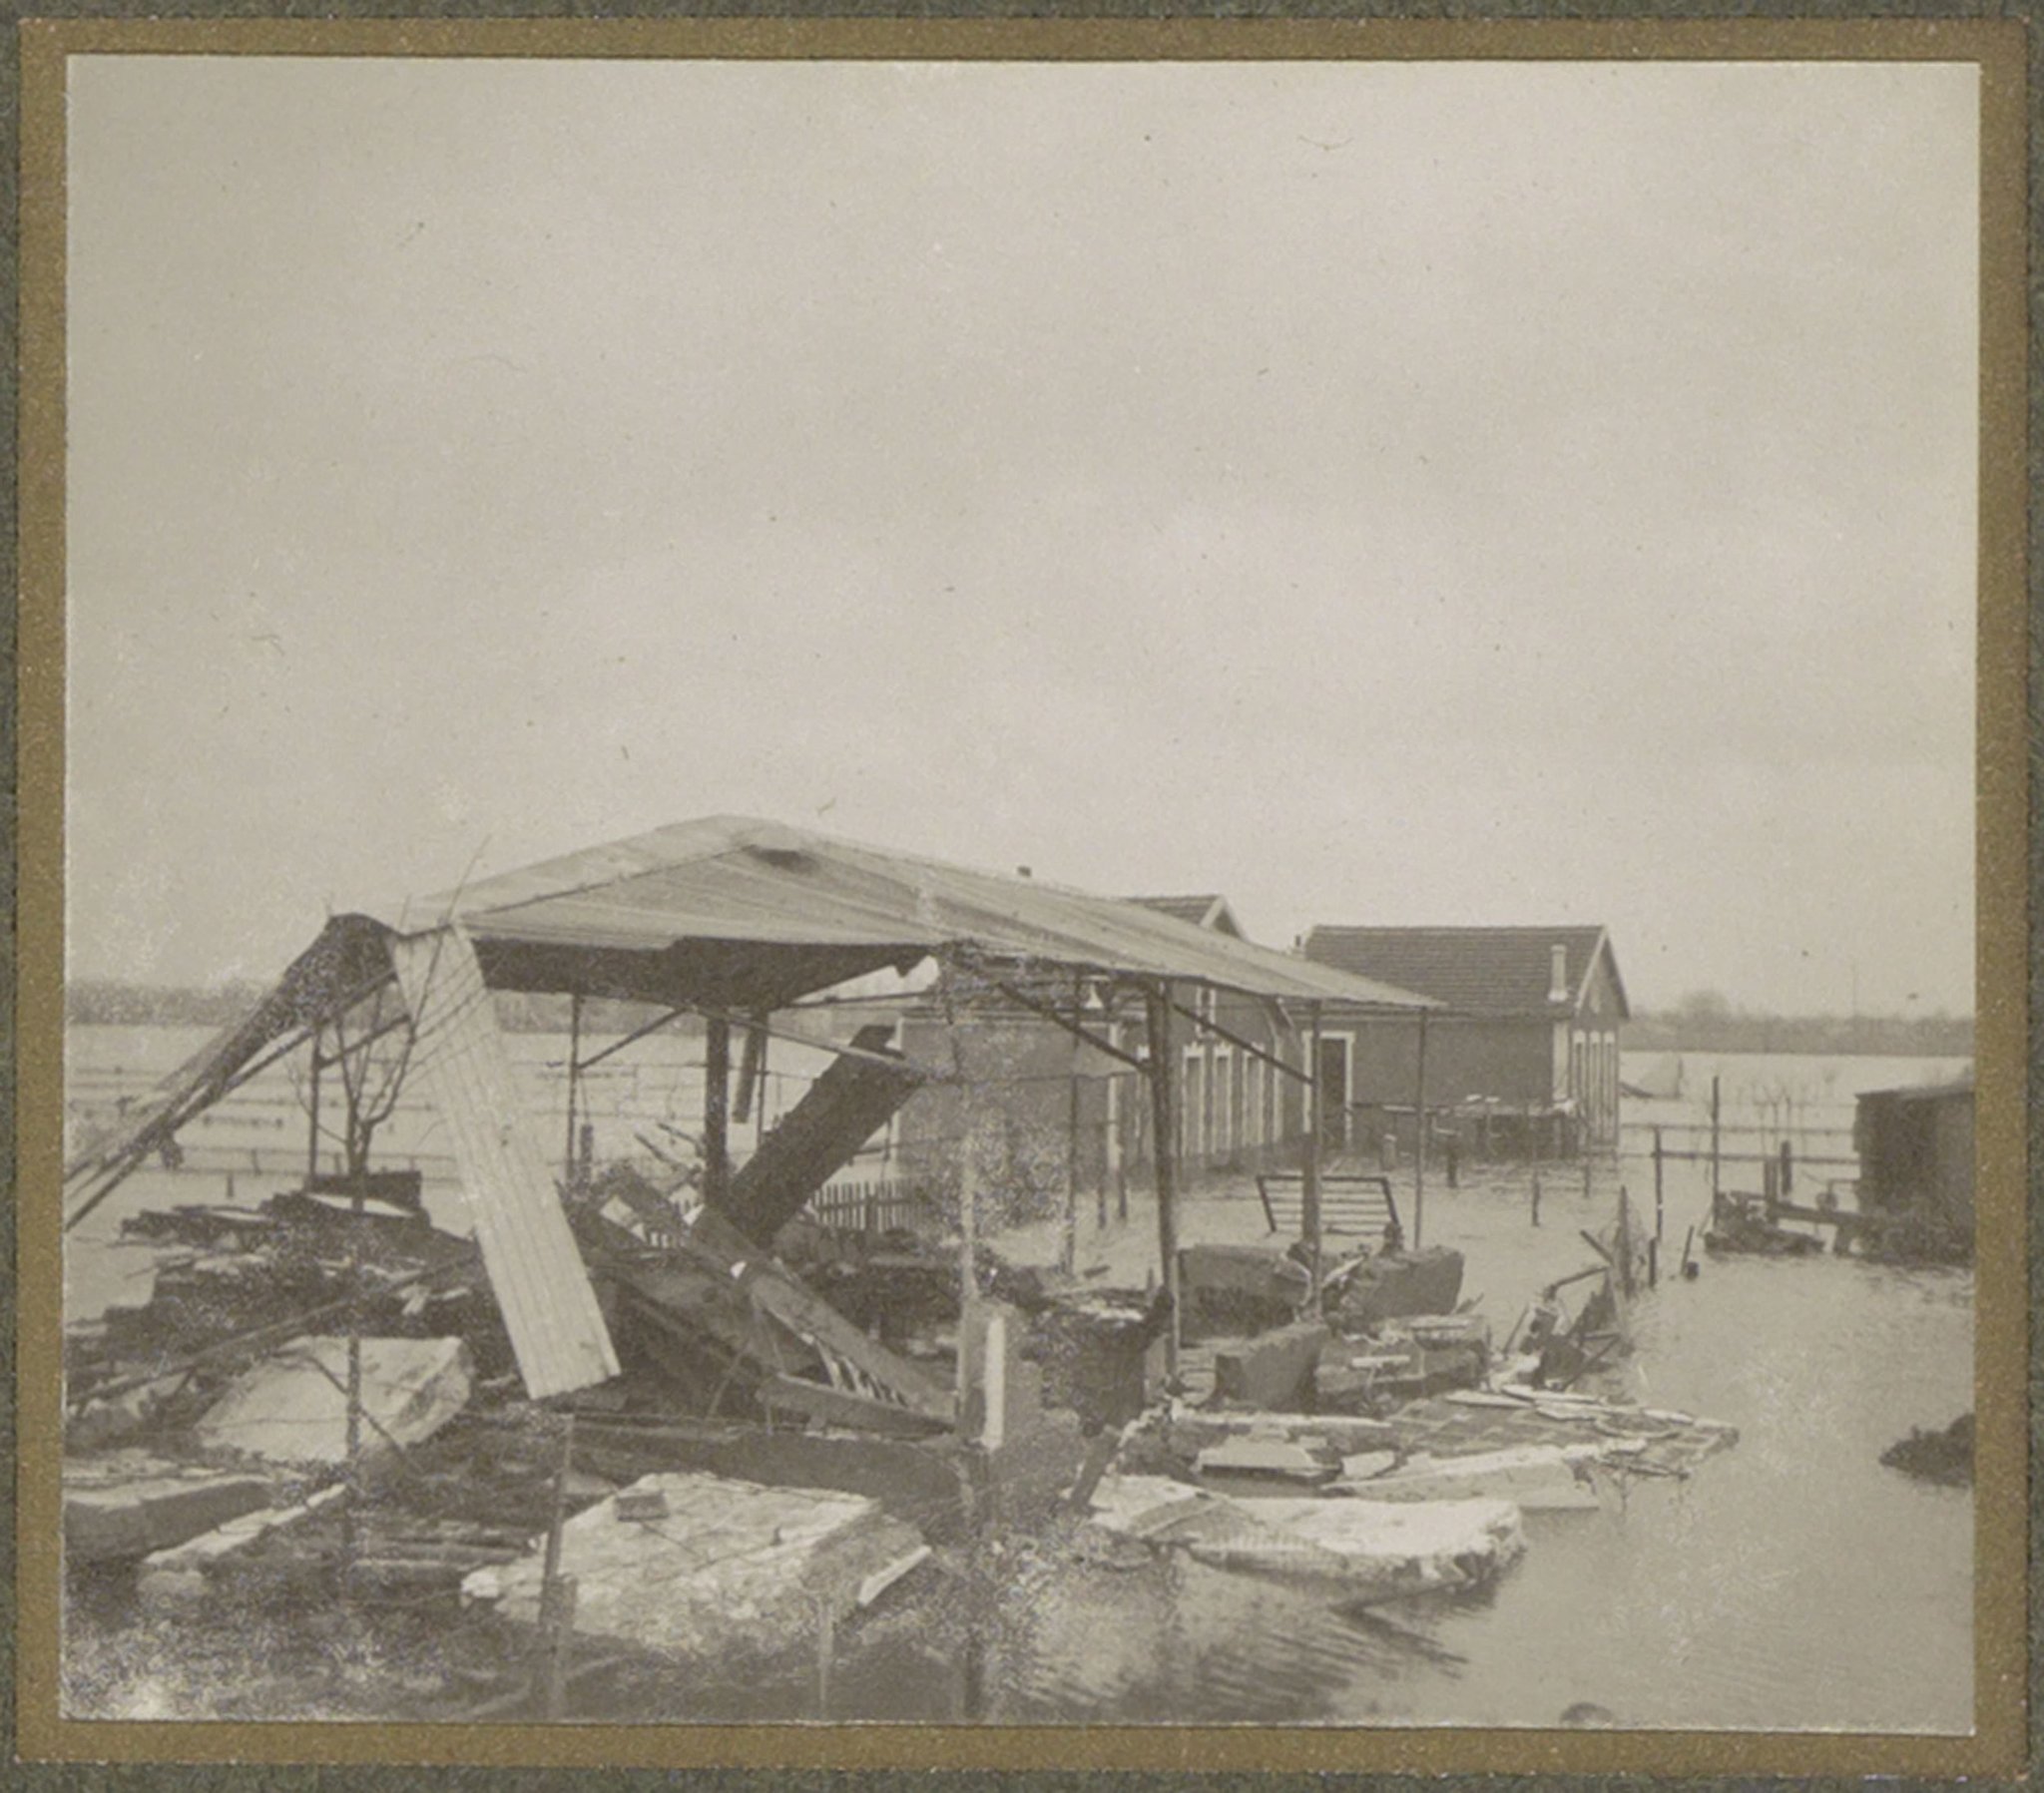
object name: photograph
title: Verwoeste schuur op ondergelopen land in een buitenwijk van Parijs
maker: g. dangereux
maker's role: fotograaf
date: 1901-1910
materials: photographic support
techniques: matte daylight collodion silver print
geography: paris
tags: barn, flood (+ landscape with figures, staffage), paris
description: Onderdeel van fotoalbum overstroming Parijs en voorsteden 1910.